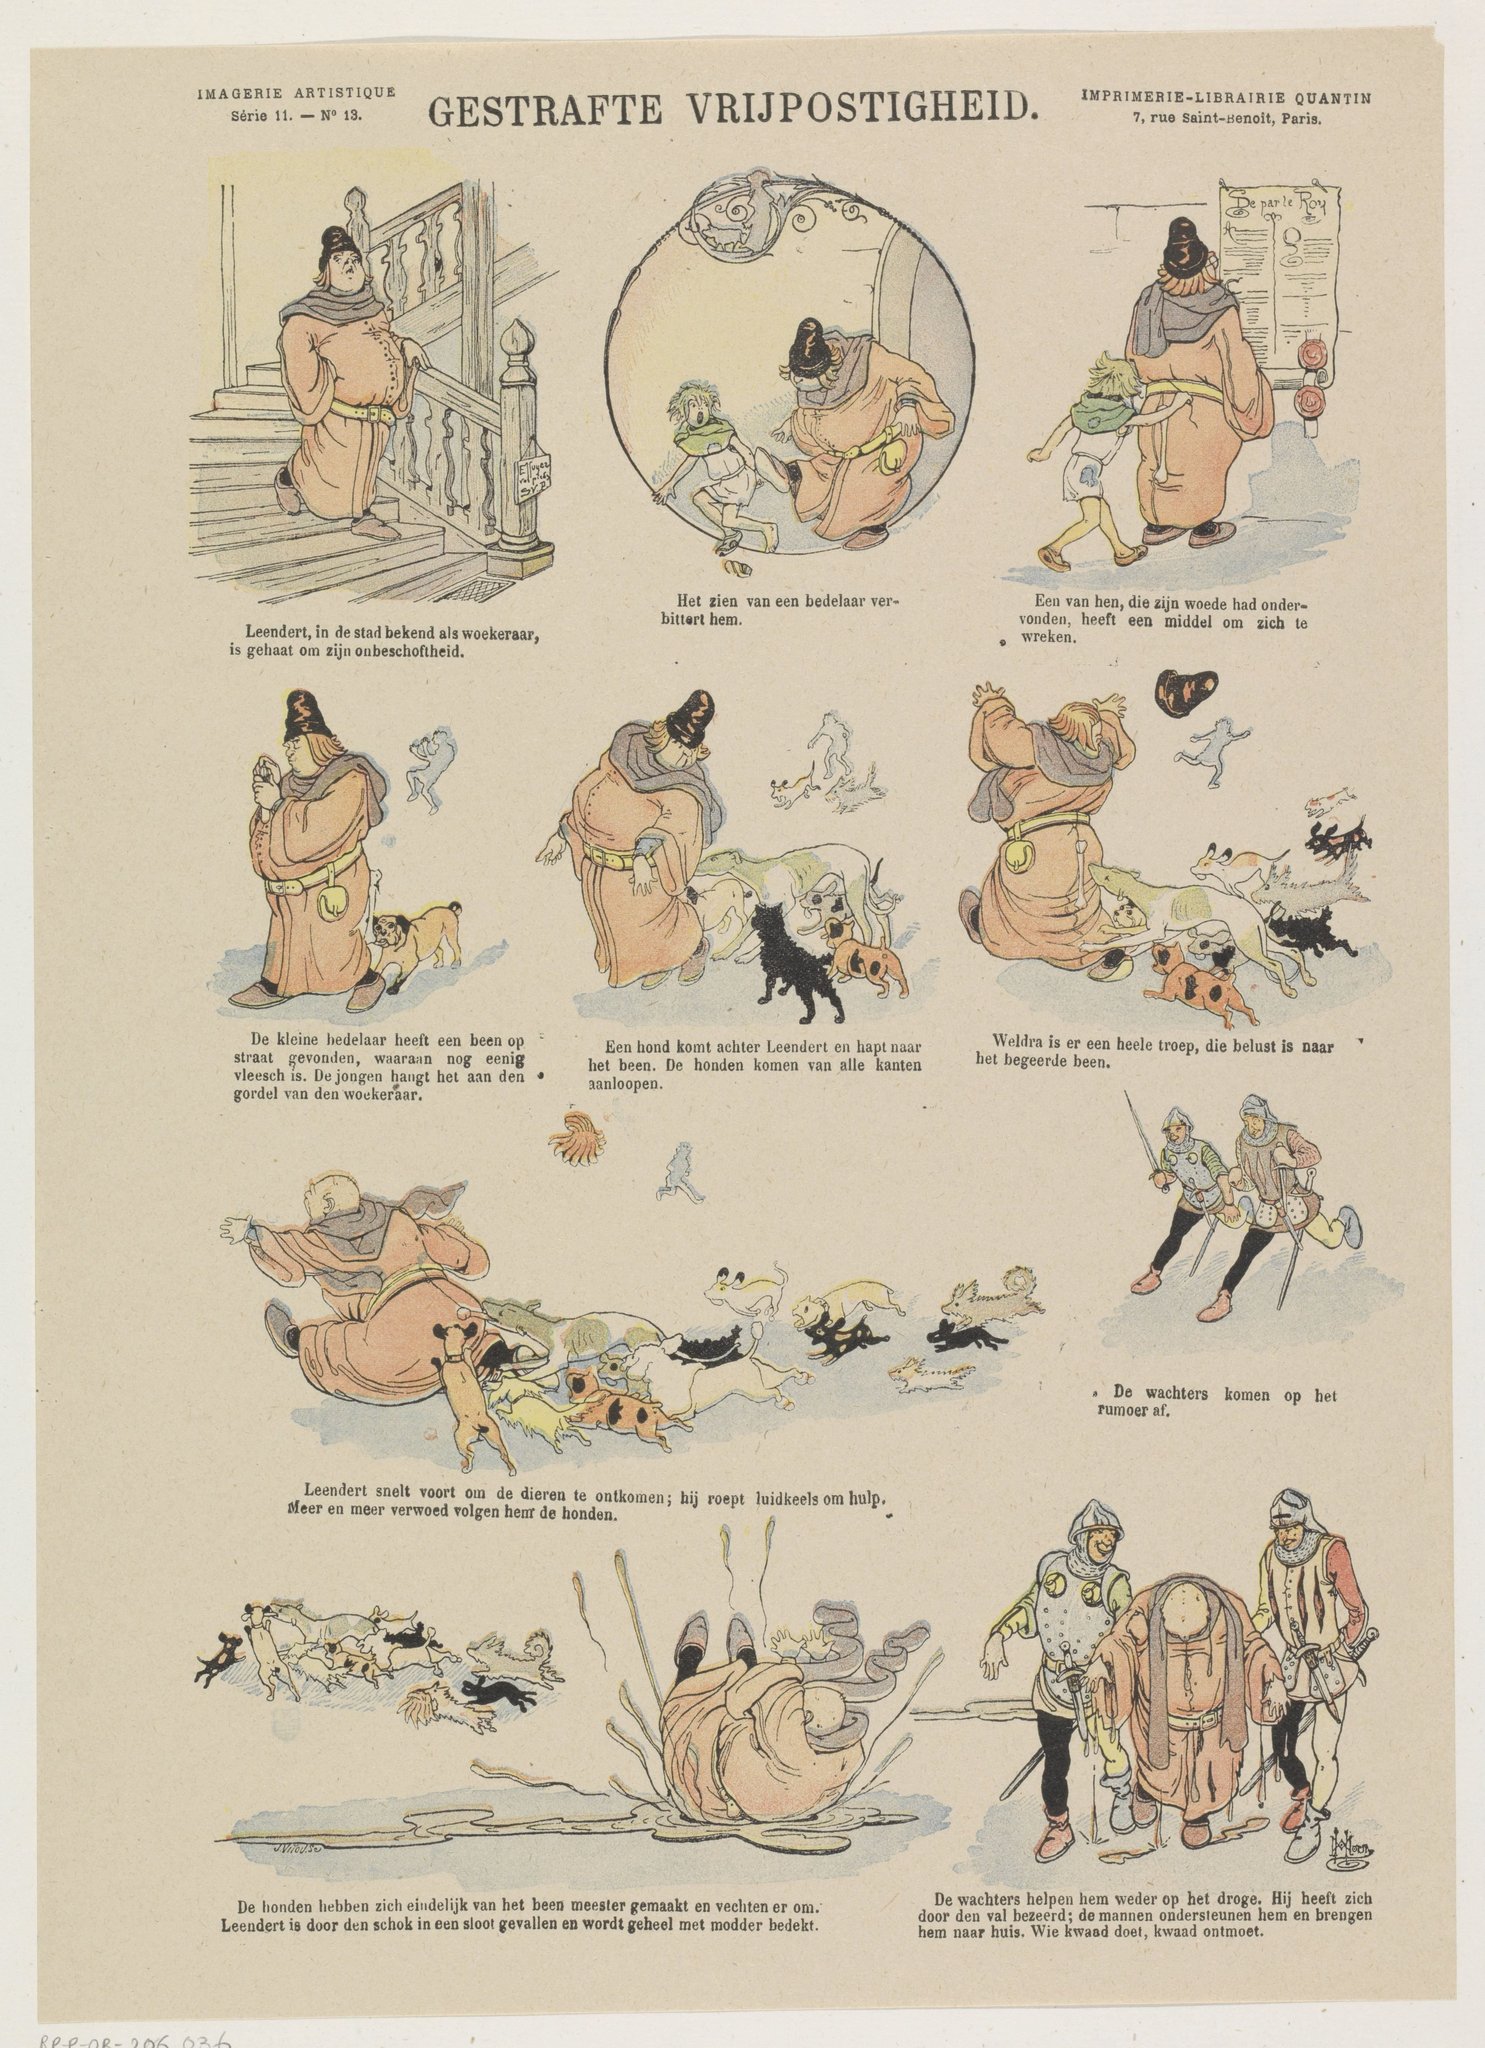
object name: print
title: Imagerie Artistique / Série 11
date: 1876-1890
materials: paper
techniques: lithograph, letterpress printing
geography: paris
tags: tales and fairy tales, beggar, dog with bone, dog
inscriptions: collector's mark: Lugt 2760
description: Blad met 10 voorstellingen van een bedelaar die wraak neemt op de onbeschofte Leendert, door hem een bot aan te binden waar tientallen honden op afkomen. Onder elke afbeelding een onderschrift. Genummerd linksboven: Série 11. - No. 13.